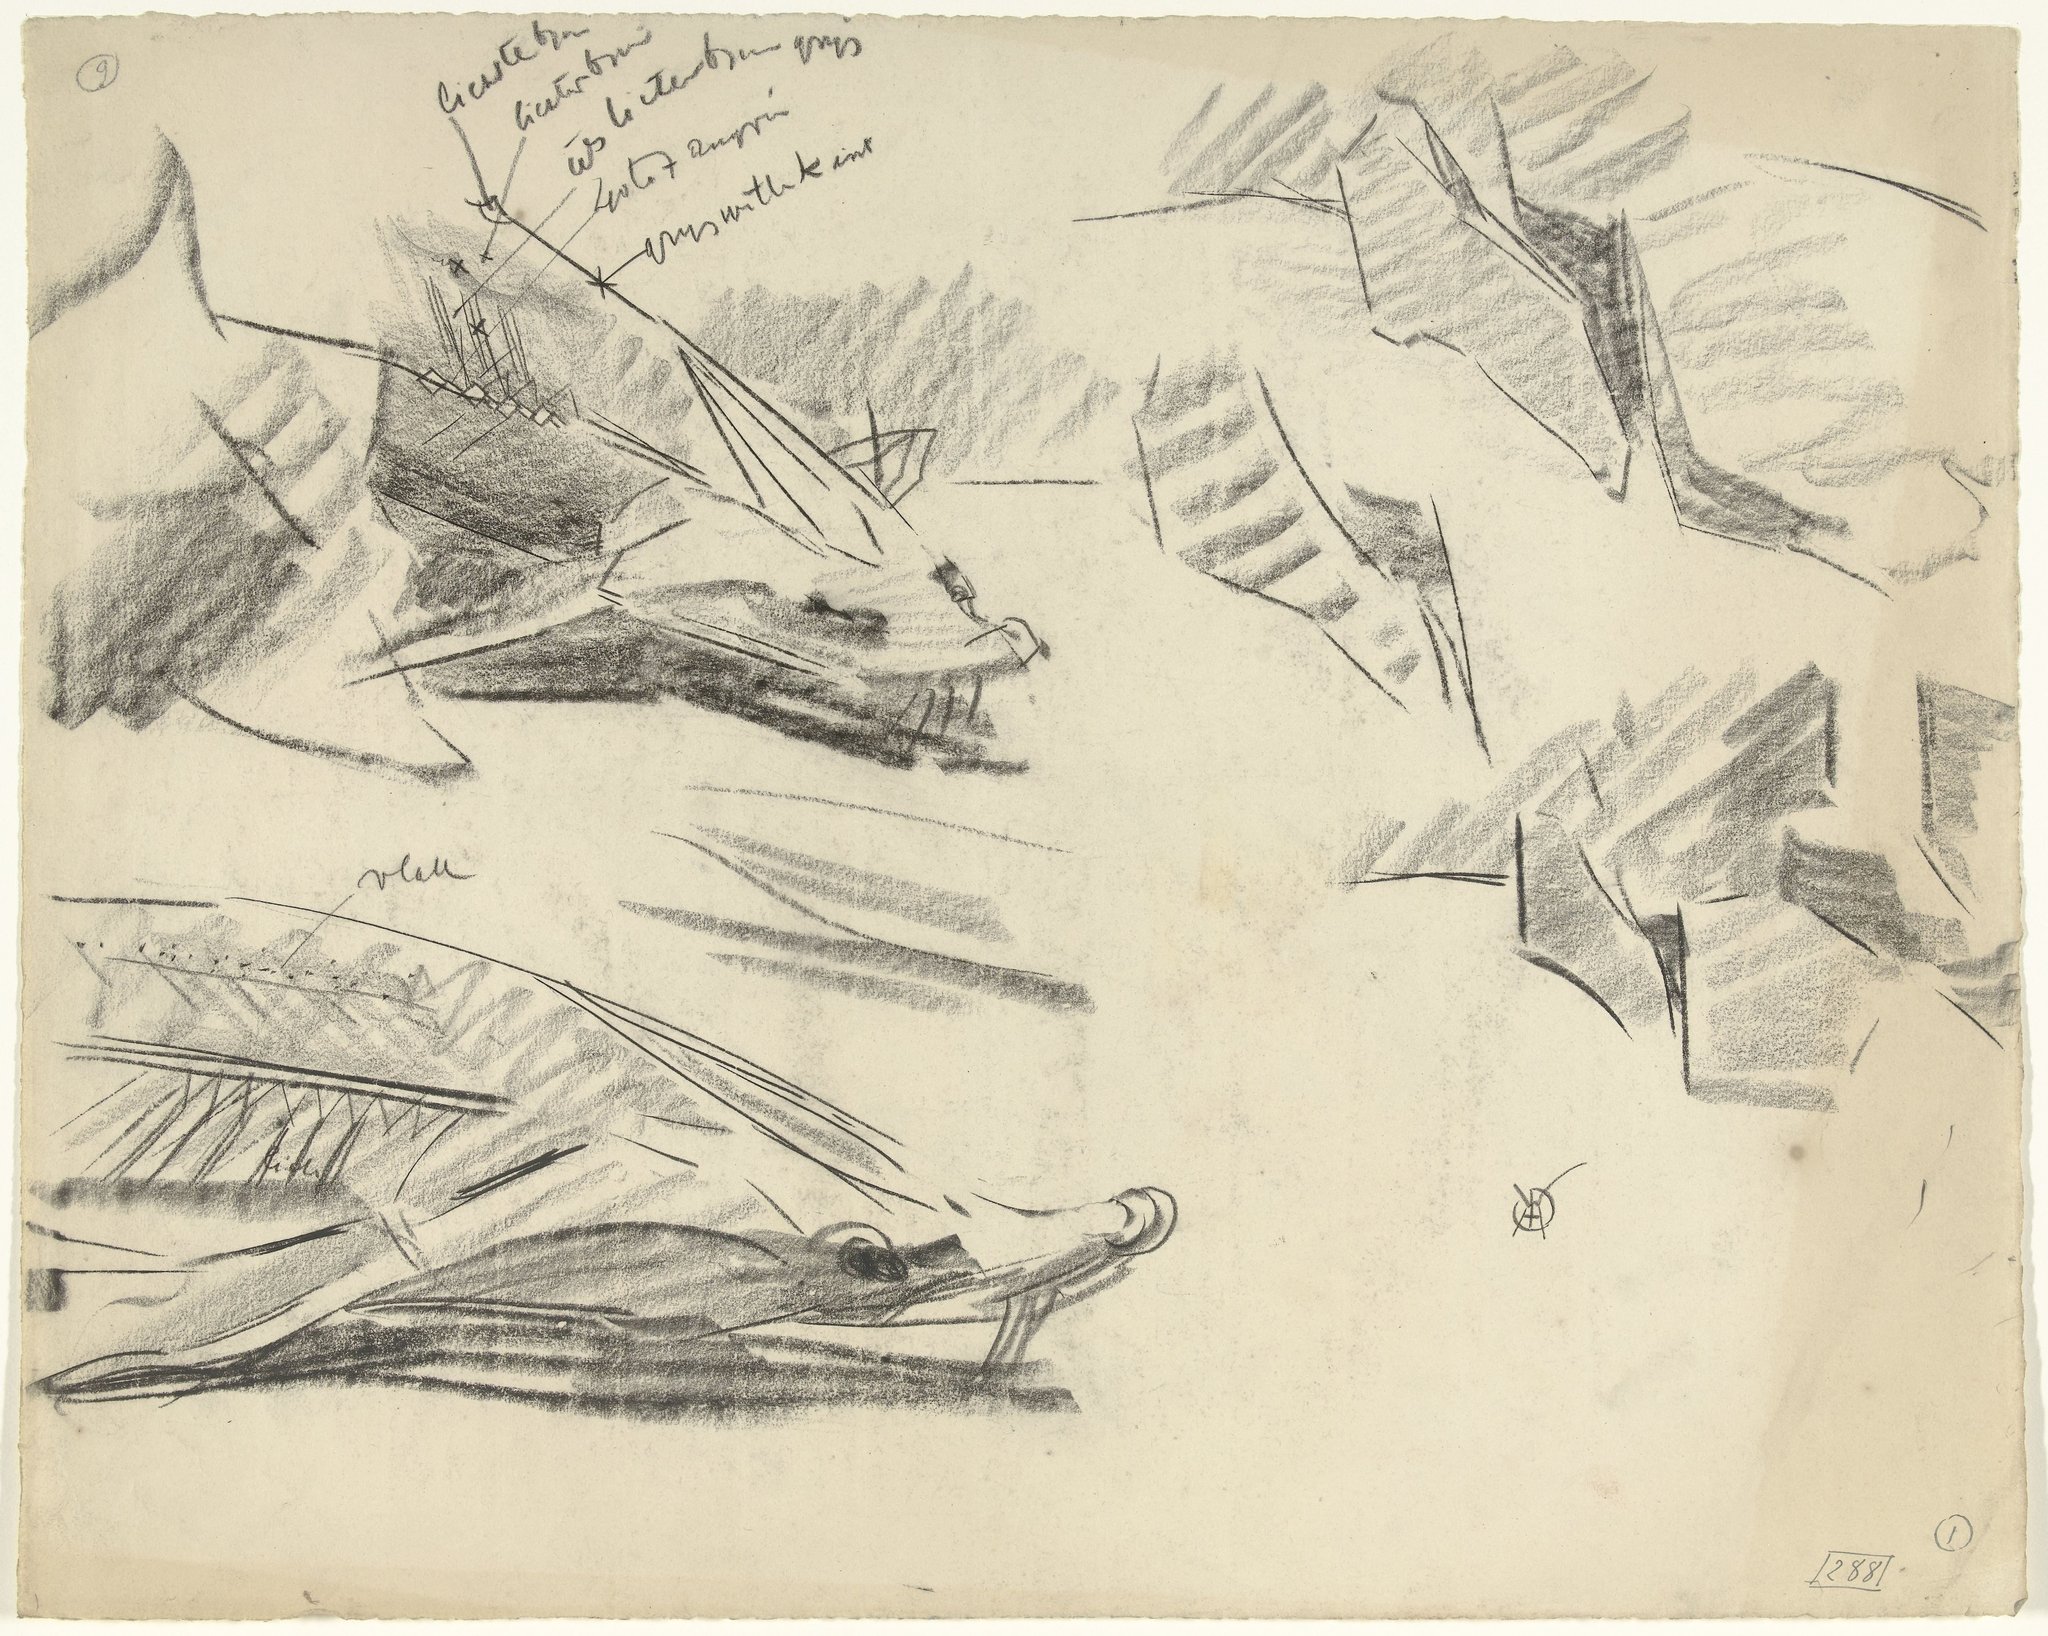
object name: drawing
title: Detailstudies van een sterlet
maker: gerrit willem dijsselhof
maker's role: designer, draughtsman, print maker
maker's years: 1866-1924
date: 1876-1924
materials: chalk, paper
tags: bony fishes